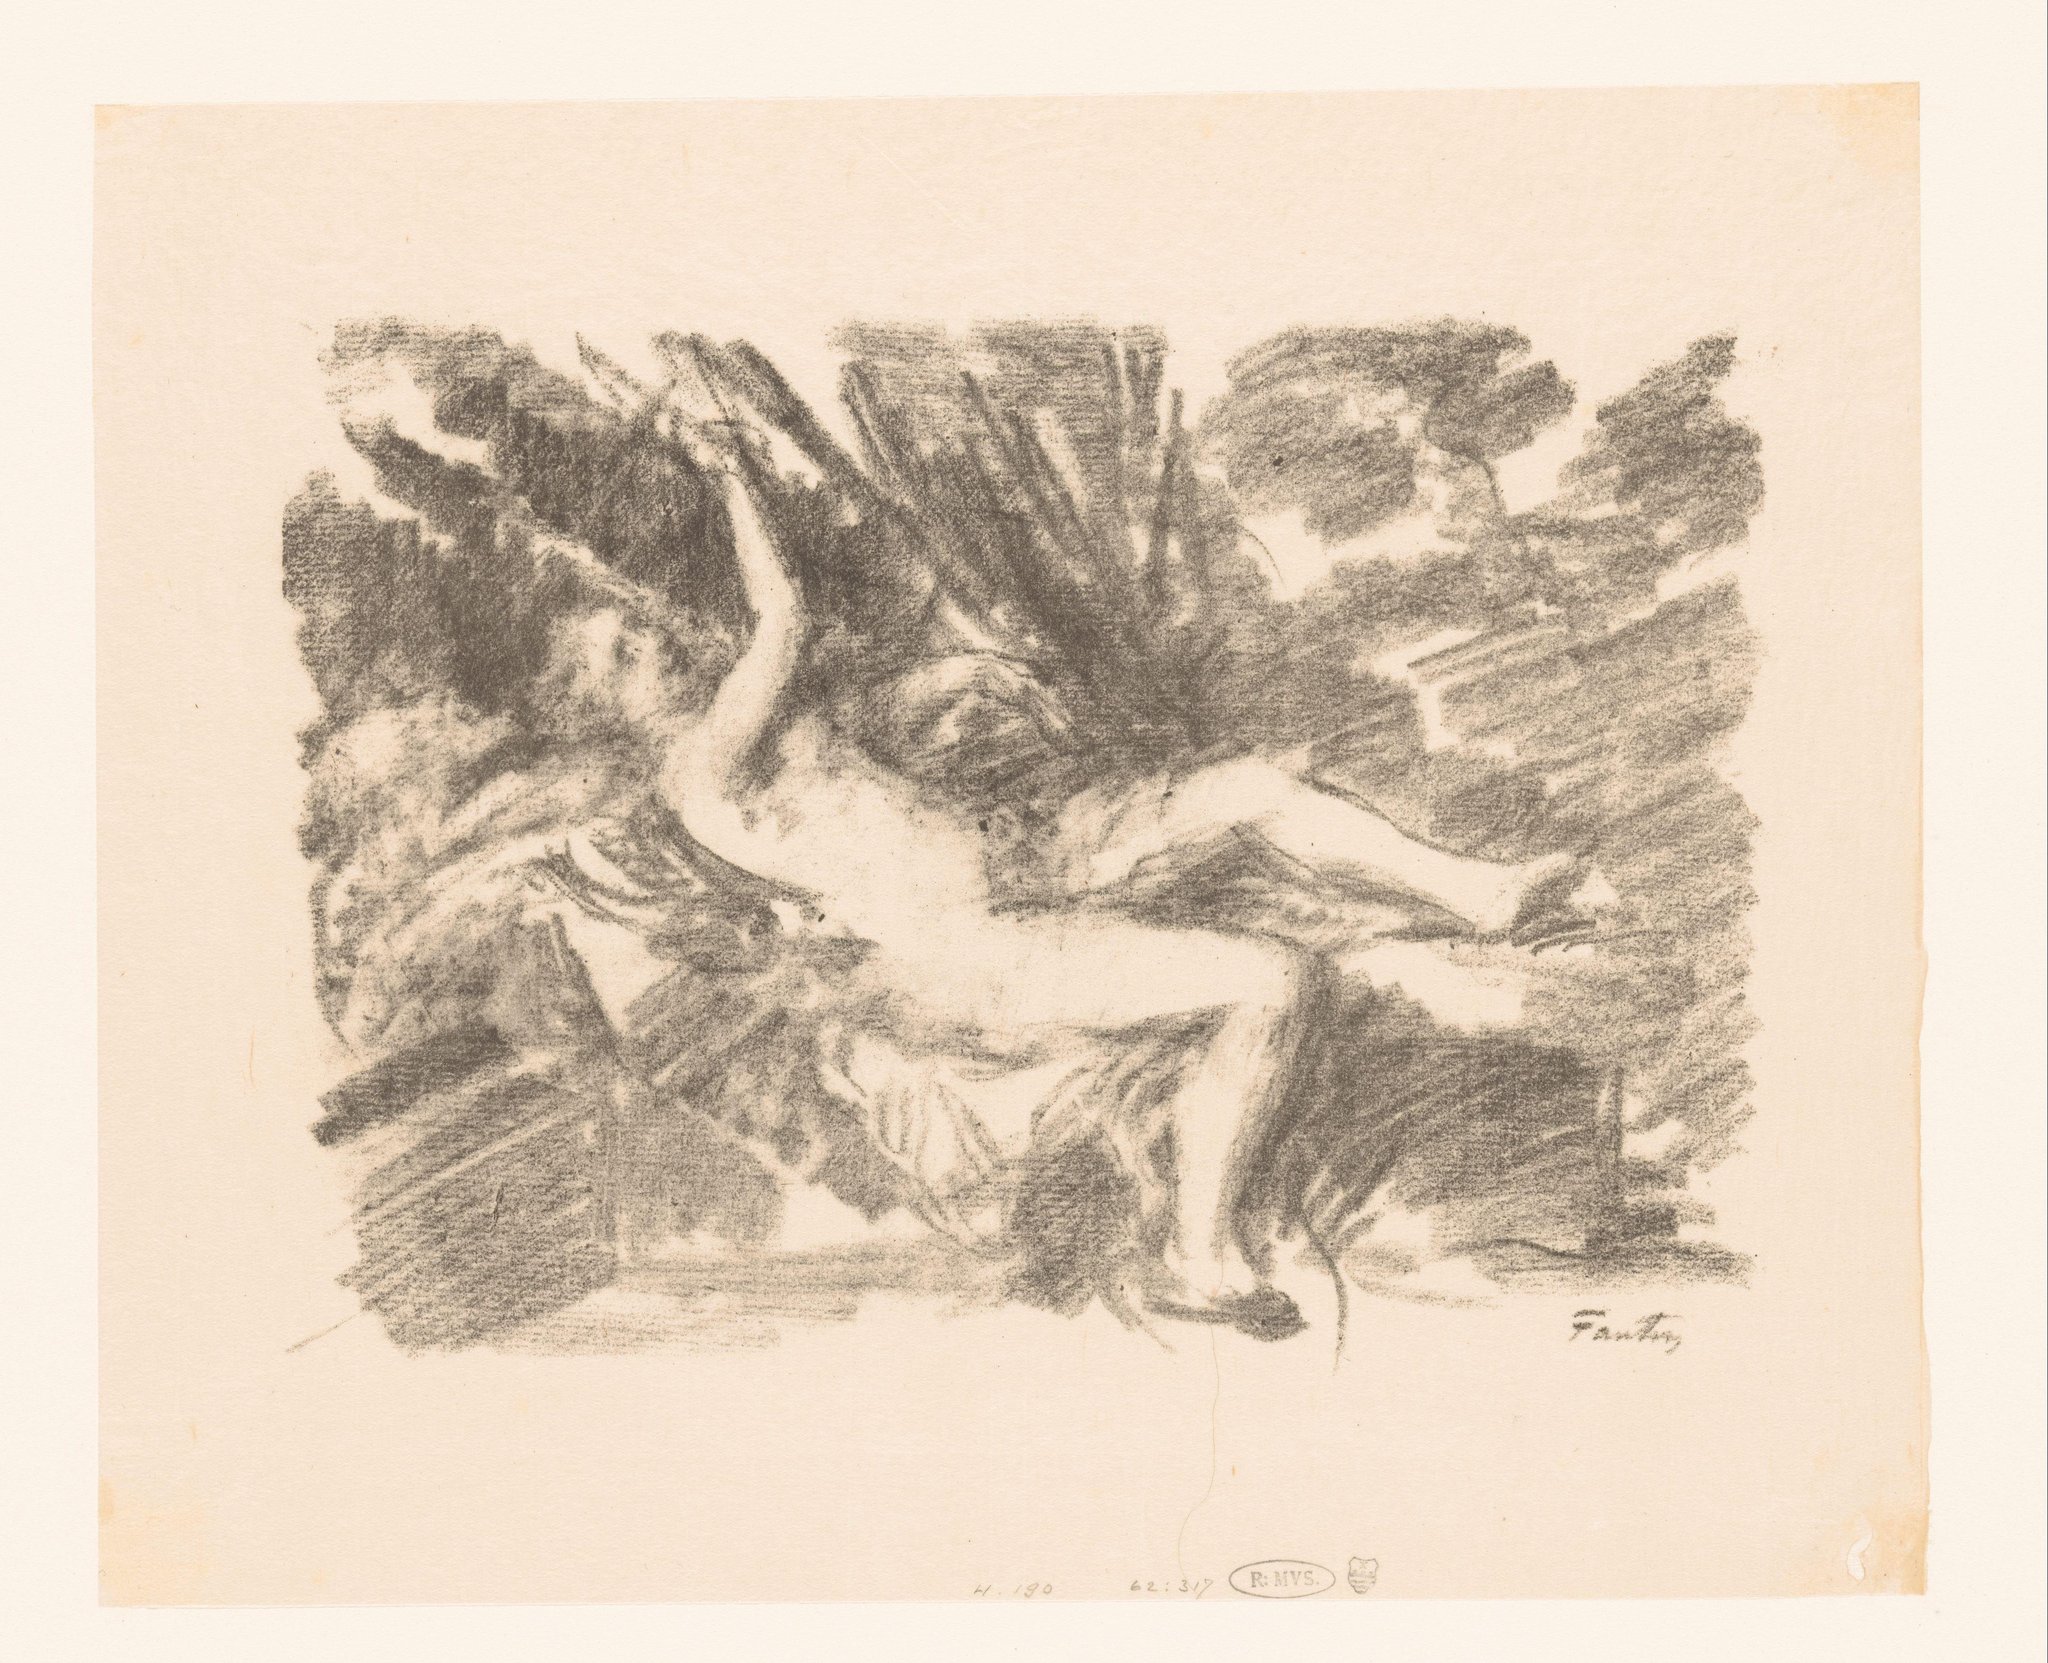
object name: book illustration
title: Le Réveil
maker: henri fantin-latour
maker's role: draughtsman, print maker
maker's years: 1836-1904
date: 1906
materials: paper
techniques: lithography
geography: paris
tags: woman (showing herself) undressed, quasi-nude, waking up, the (nude) human figure; 'corpo humano' (ripa) - aa - female human figure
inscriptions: collector's mark: Lugt 2228a, collector's mark: Lugt 2760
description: Proefdruk voor prent, gebruikt voor: L. Bénédite, L'oeuvre de Fantin-Latour, Parijs 1906.